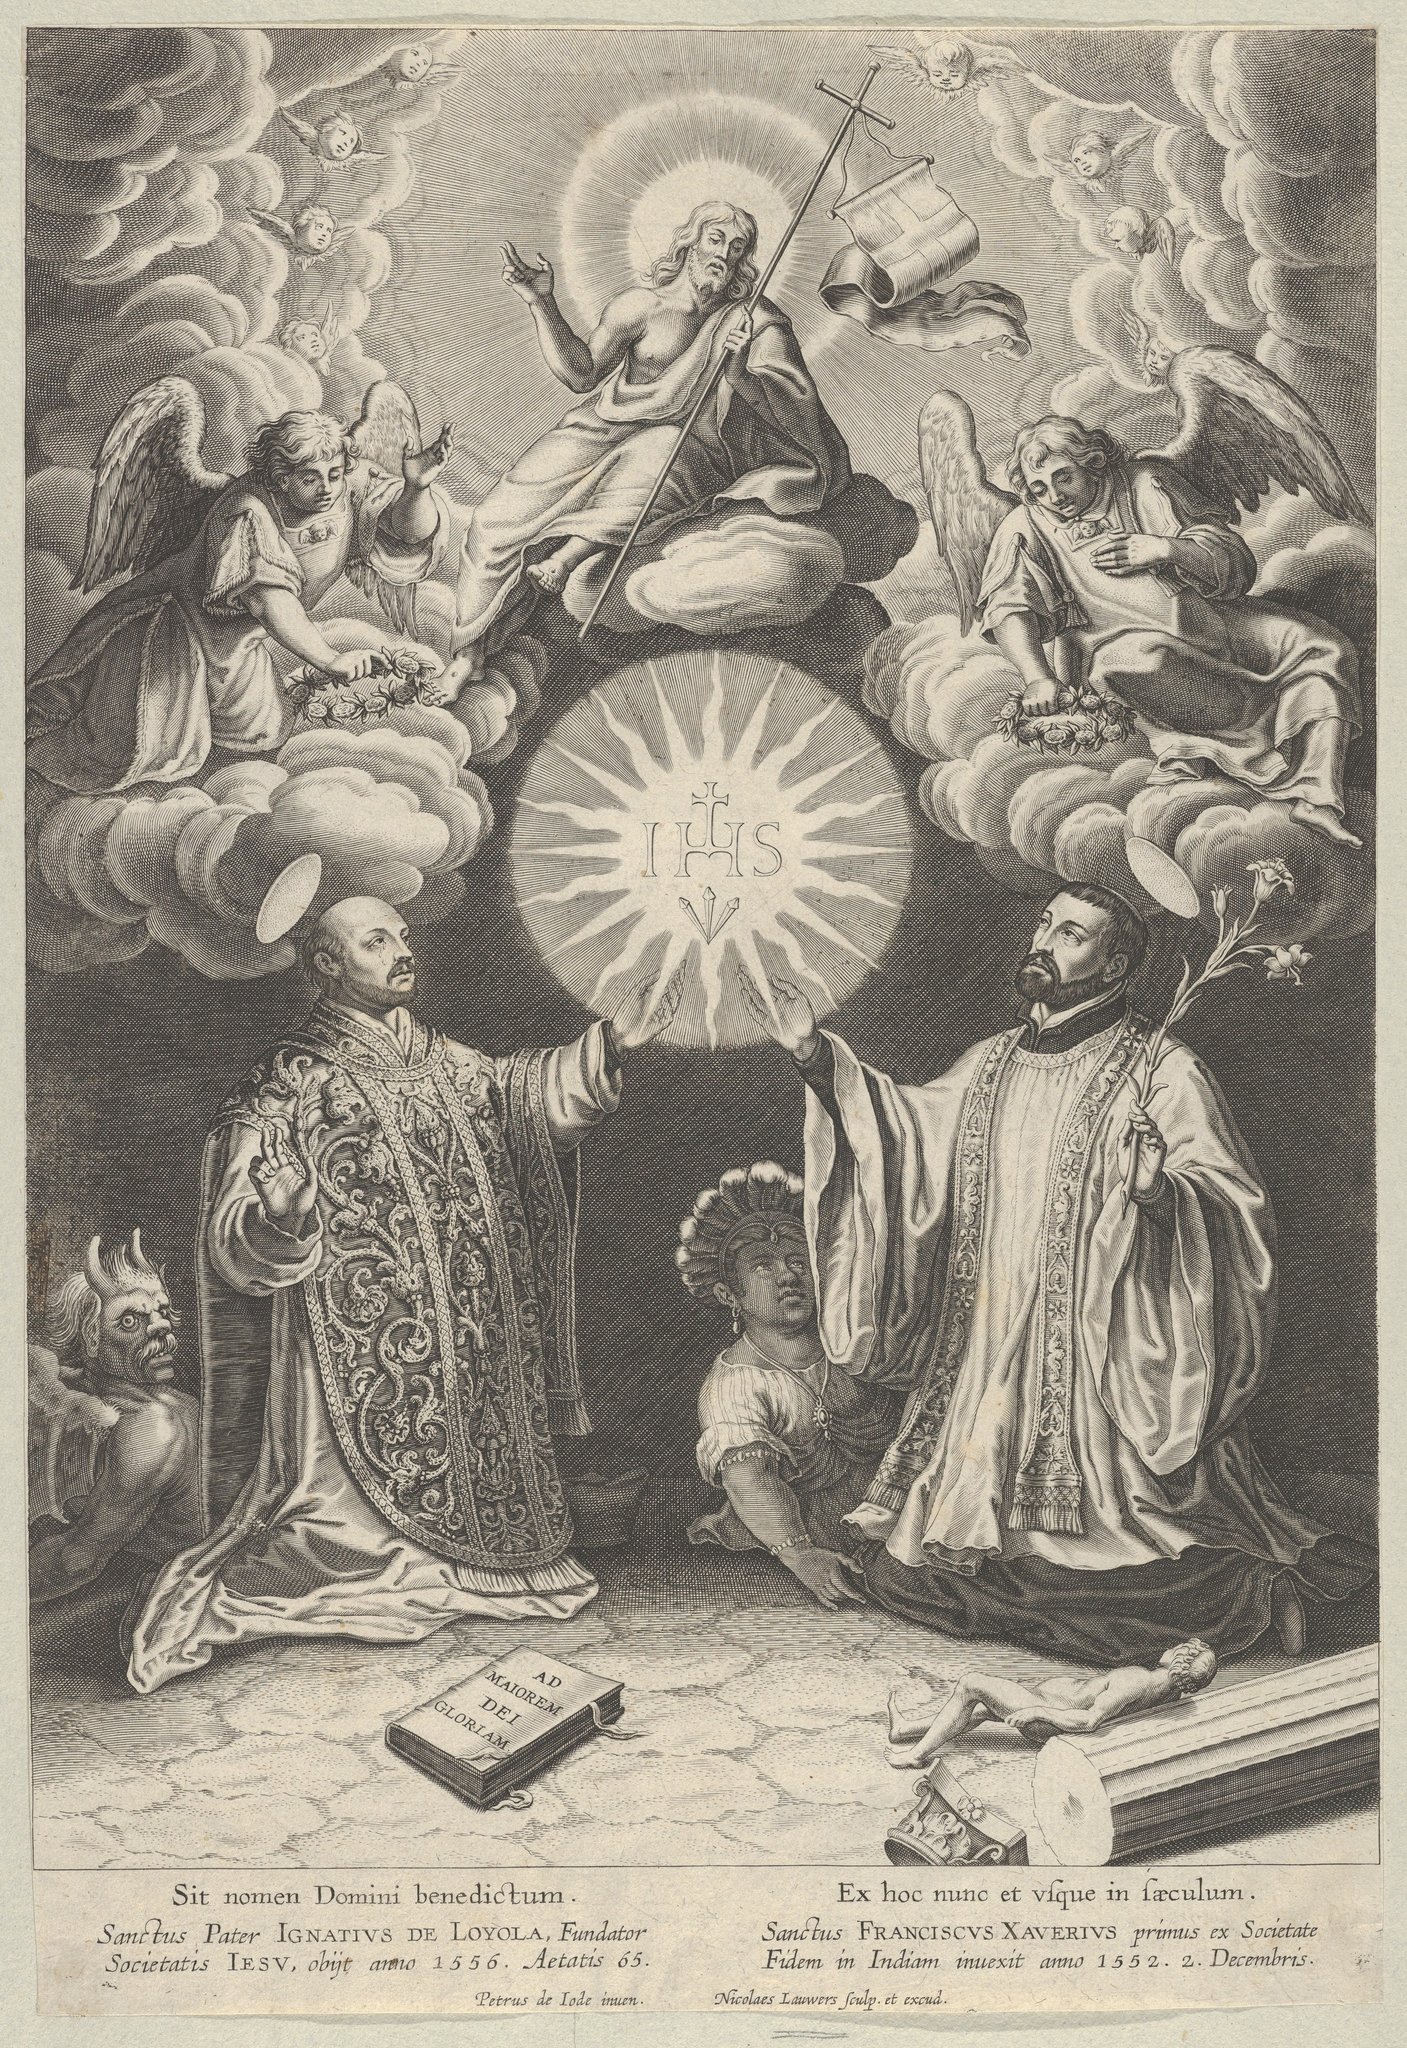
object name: print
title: Christ, Ignatius of Loyola and Francis Xavier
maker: pieter de jode (i)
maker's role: artist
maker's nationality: netherlandish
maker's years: 1570-1634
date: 1601-1700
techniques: engraving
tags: angels,christ,saints